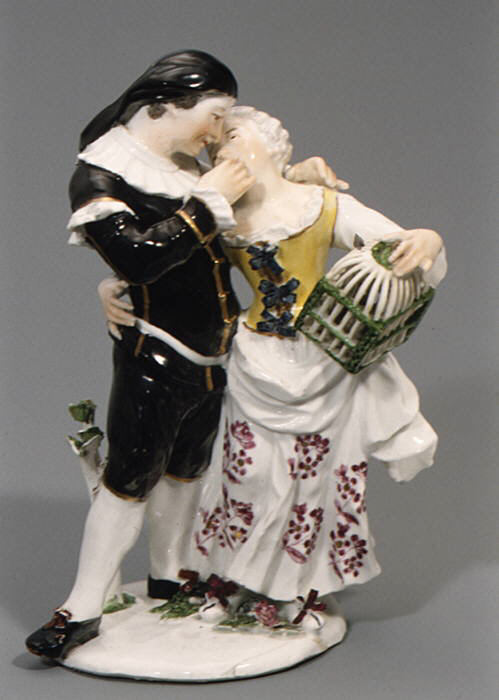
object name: group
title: Scaramouche and Columbine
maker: royal porcelain manufactory, berlin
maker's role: manufactory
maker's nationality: german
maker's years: 1763-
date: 1751-1757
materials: hard paste porcelain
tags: men,women